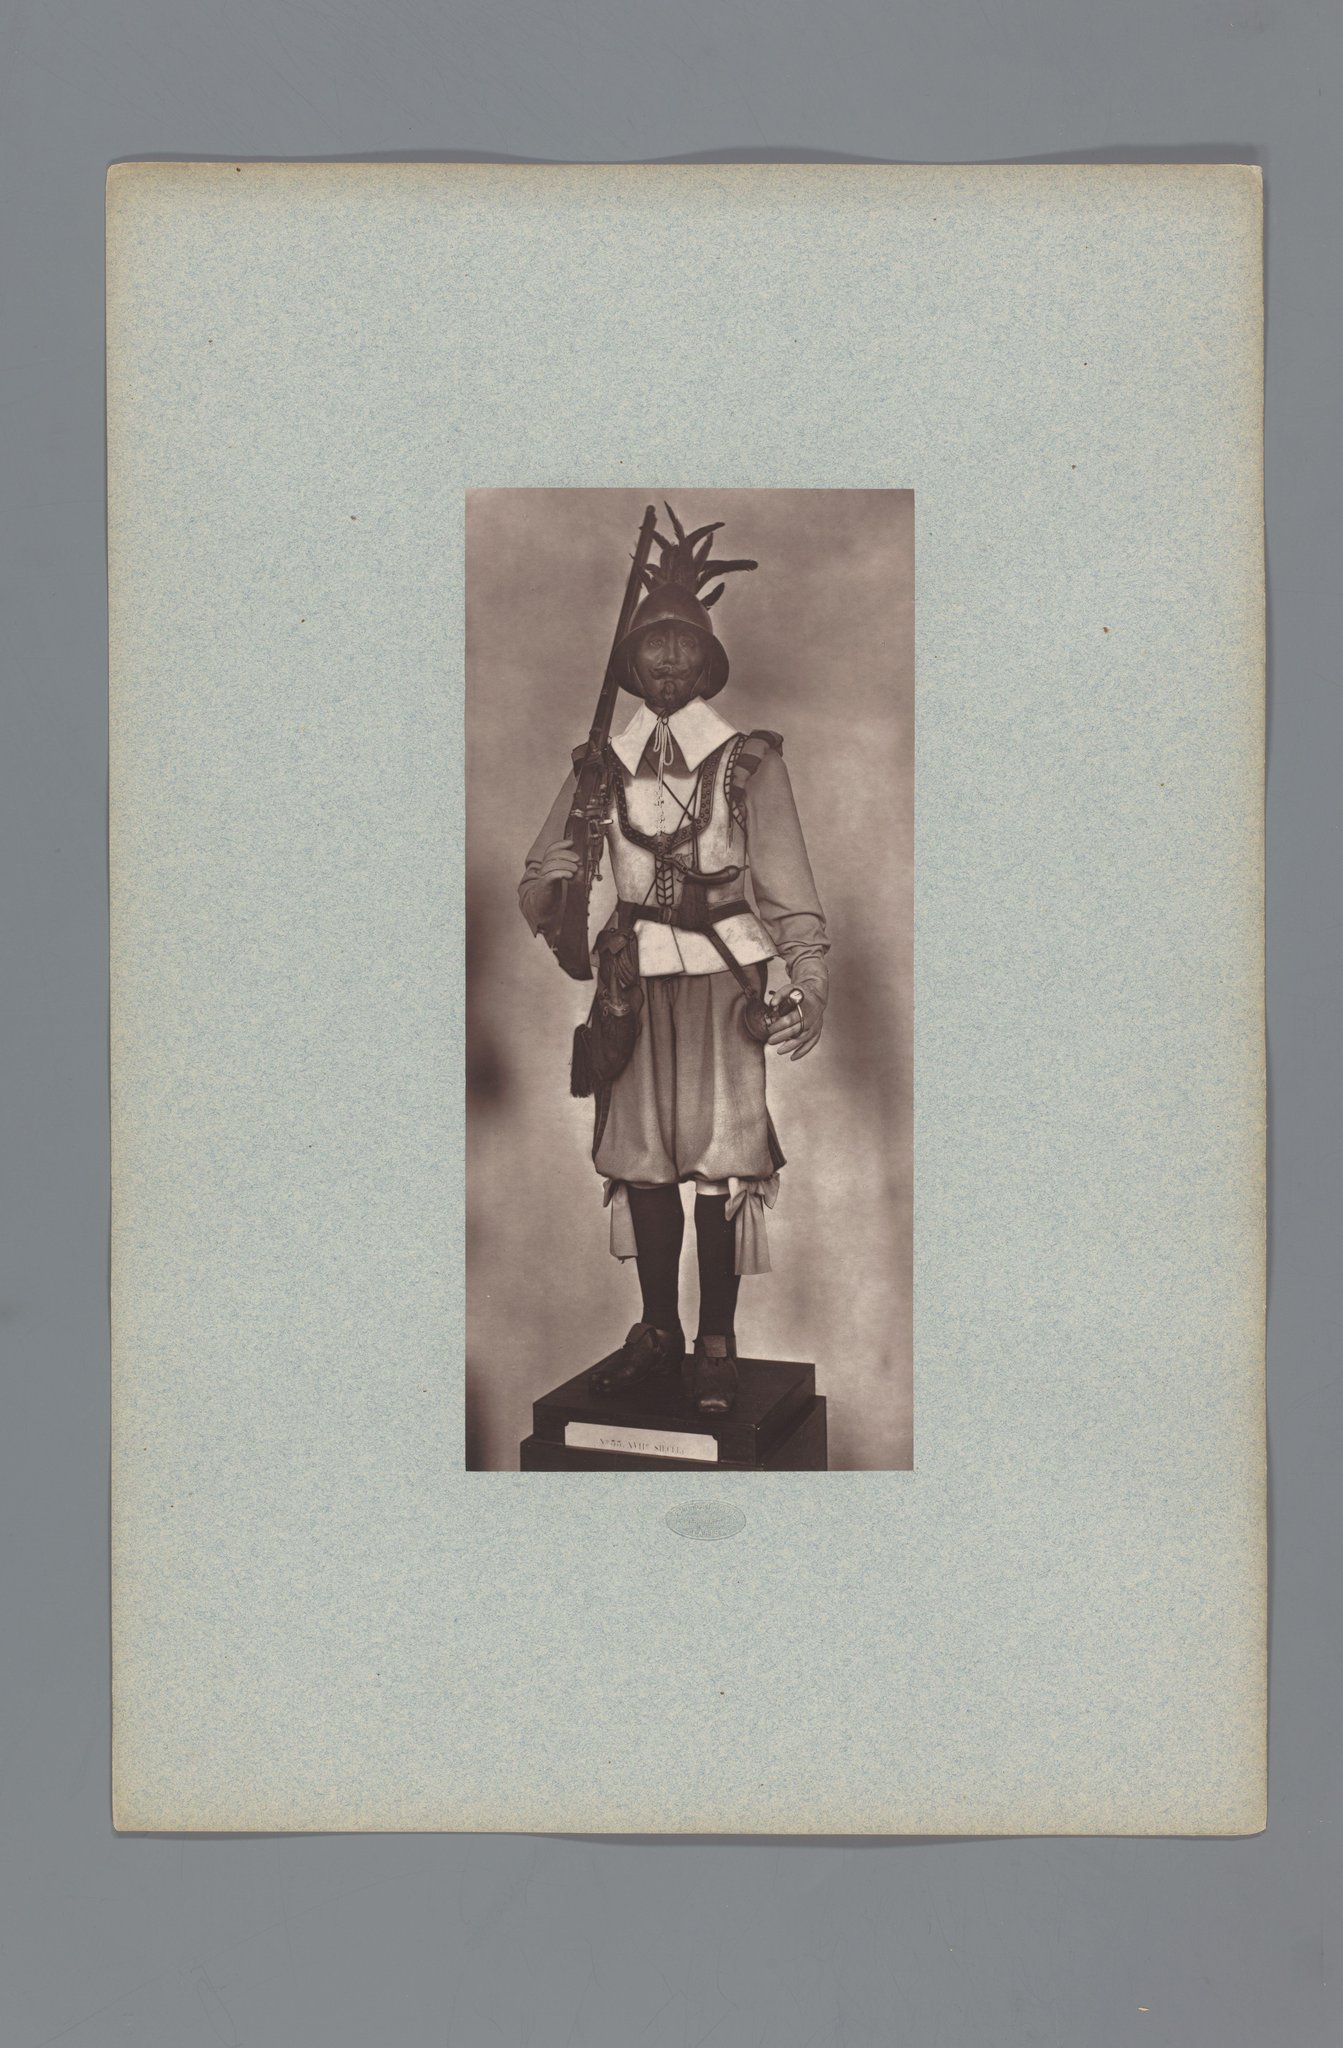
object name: photomechanical print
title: 17de-eeuws uniform met geweer uit het leger van Lodewijk XIII van Frankrijk, uit de collectie van het Musée d'Artillerie in Parijs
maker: Anonymous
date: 1877-1882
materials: paper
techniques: woodburytype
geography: paris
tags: firearms: rifle, (military) uniforms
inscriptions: check stamp: ‘PHOTOGLYPTIE/ LEMERCIER ET Cie/ PARIS’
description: Deze prent maakt deel uit van een omslag met 36 prenten, een titelblad en een lijst van afbeeldingen.